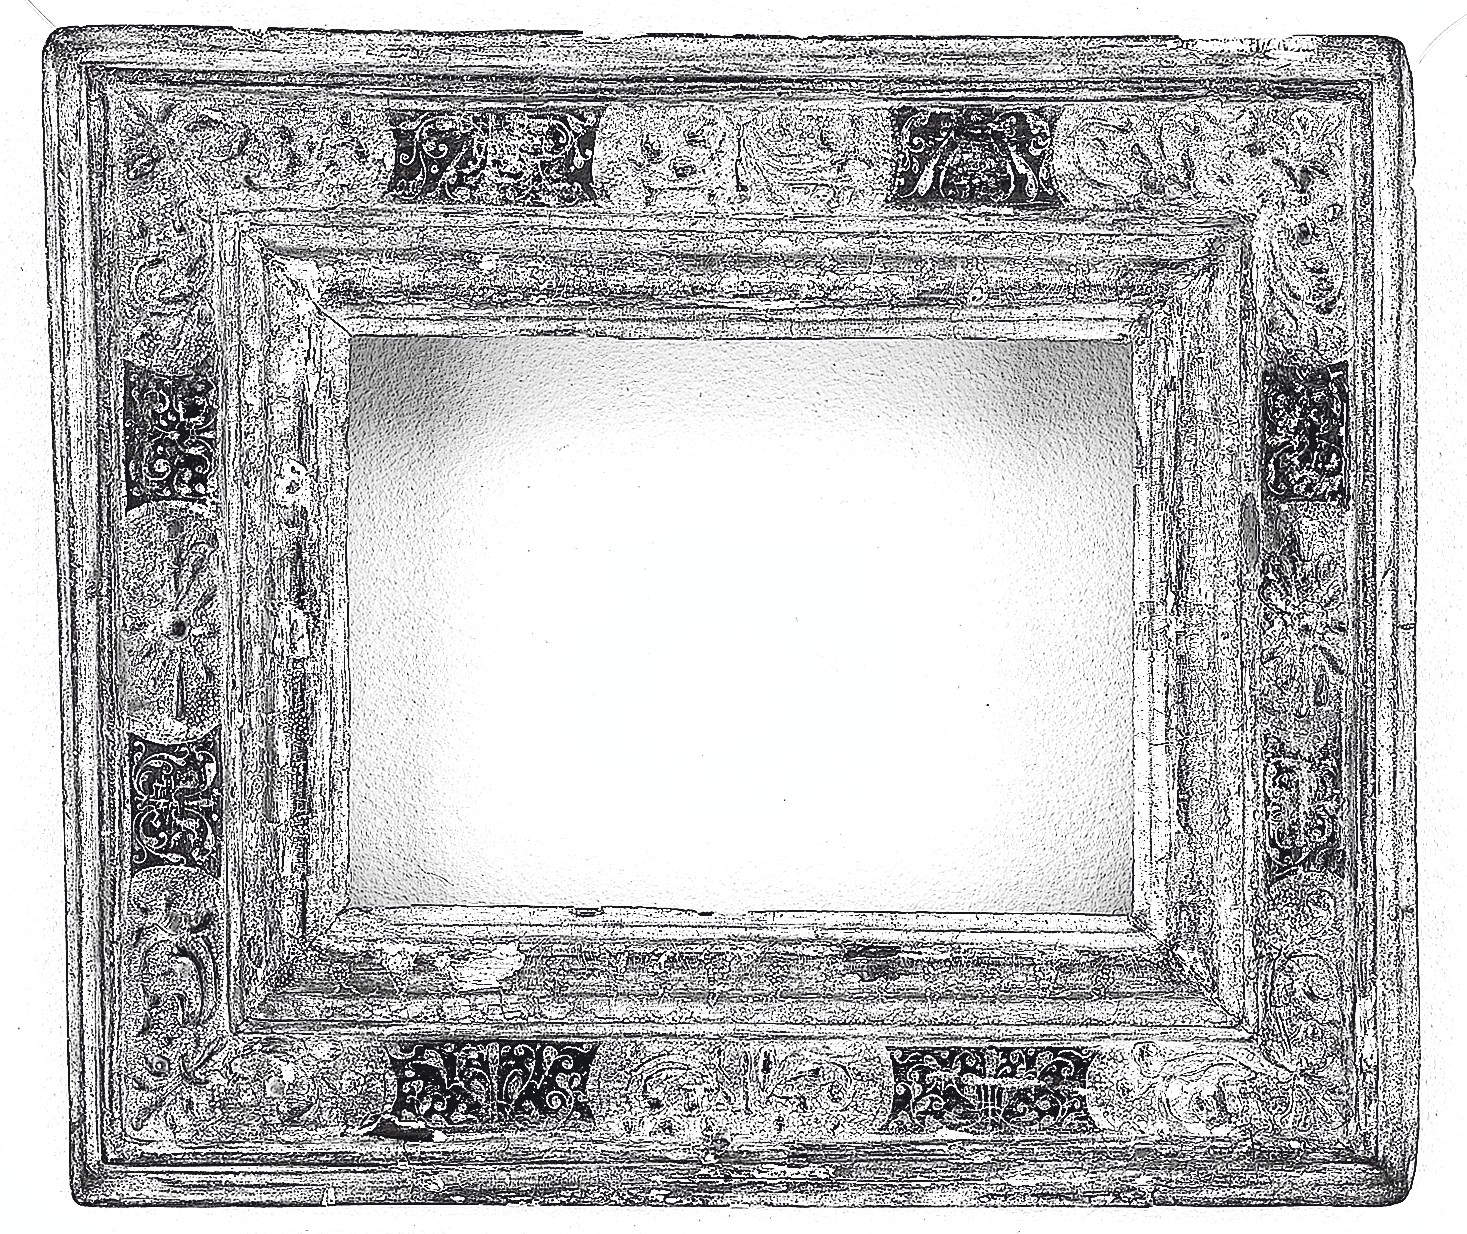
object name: frame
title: Reverse Cassetta frame (pair with 1975.1.2110)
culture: southern italian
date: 1634-1666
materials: wood